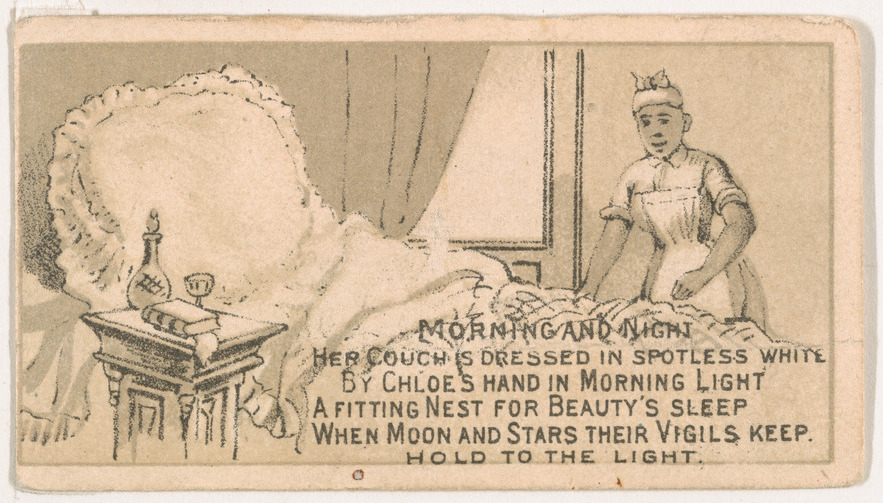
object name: print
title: Morning and Night, from the Magic Changing Cards series (N223) issued by Kinney Tobacco Company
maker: kinney brothers tobacco company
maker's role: publisher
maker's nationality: american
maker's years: 1869-2011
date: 1889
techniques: color lithograph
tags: women,beds